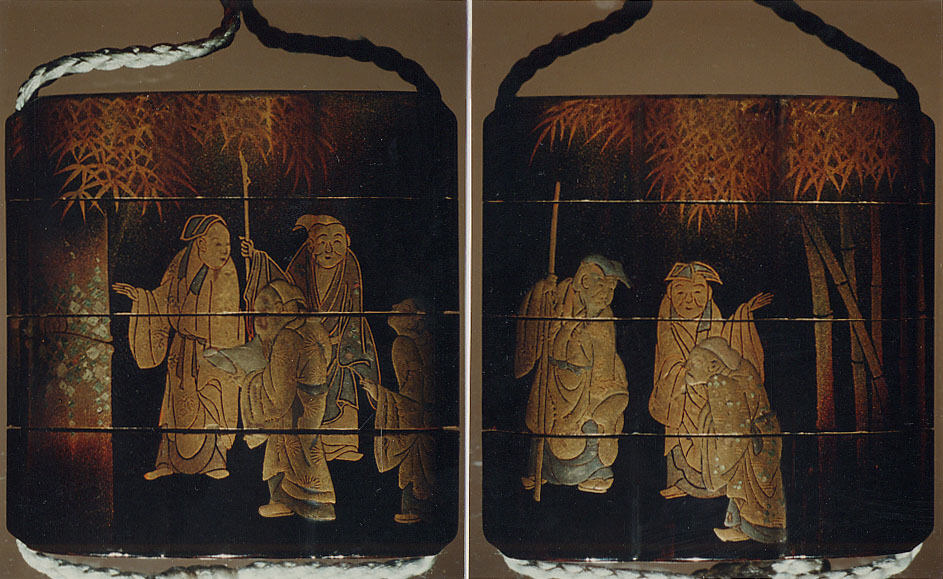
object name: inrō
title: Inrō with the Seven Sages of the Bamboo Grove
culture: japanese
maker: tōyō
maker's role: artist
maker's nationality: japanese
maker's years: 1764-1771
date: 1751-1800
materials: coral, gold, gold foil, lacquer, silver, wood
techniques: hiramakie, lacquer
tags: men,bamboo